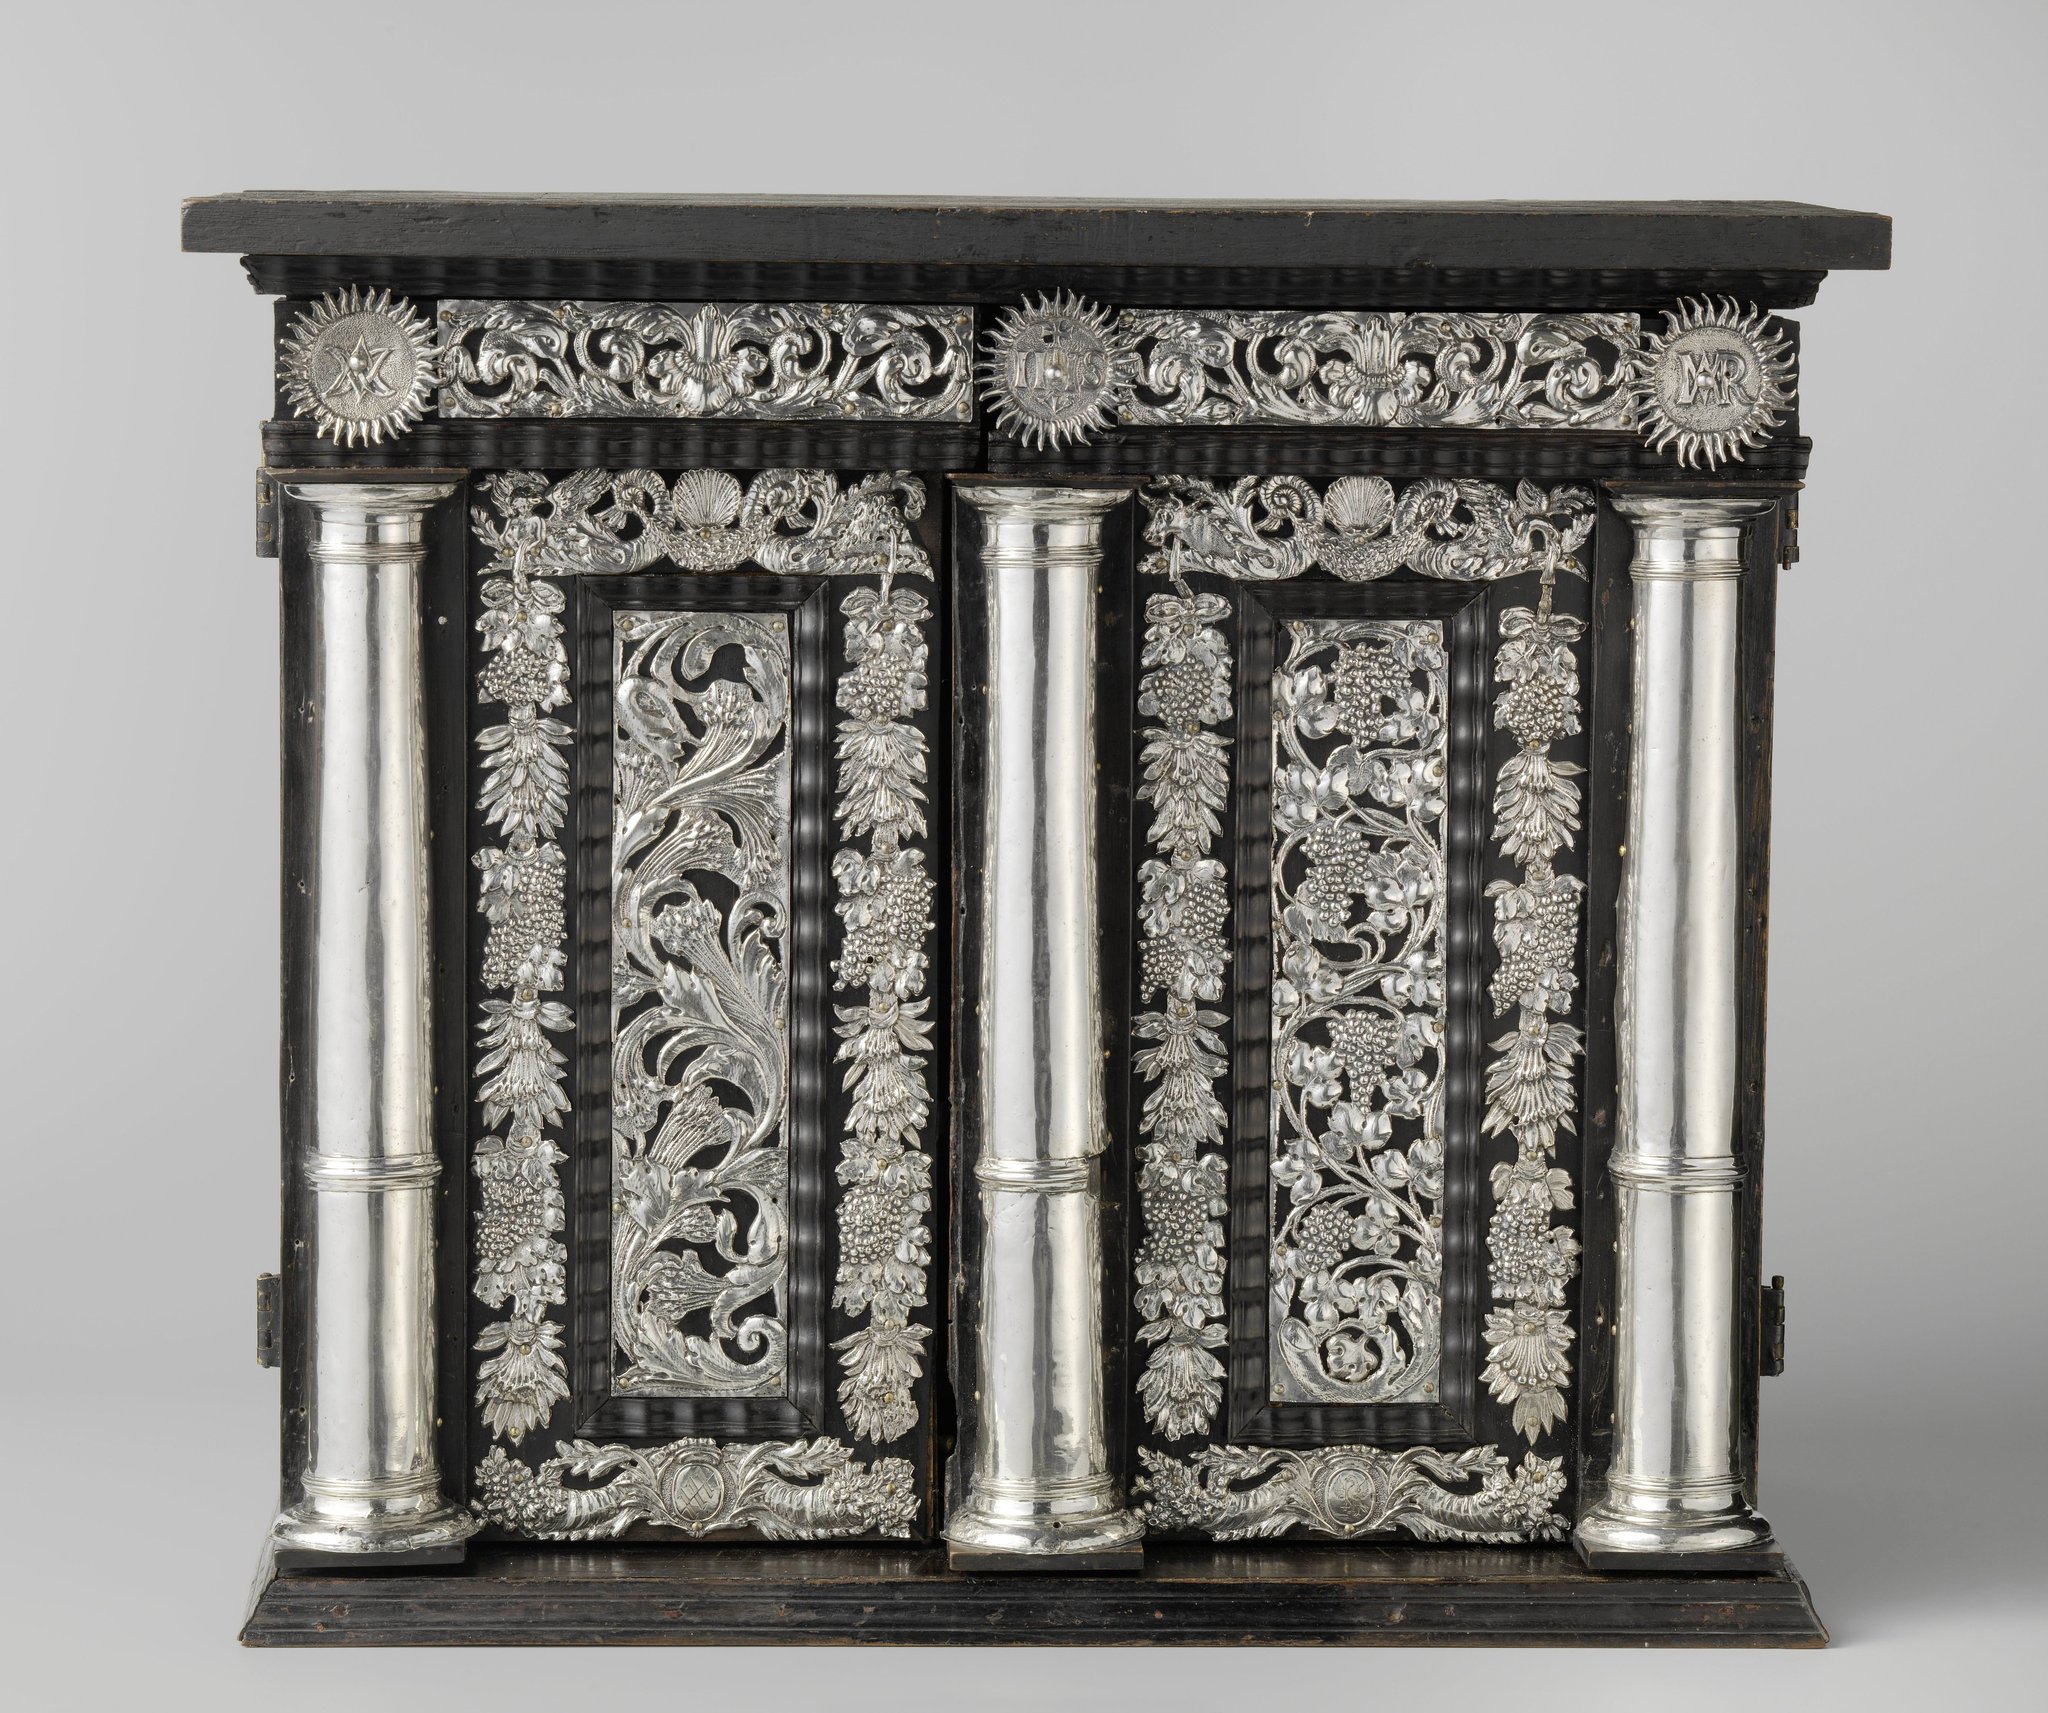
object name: tabernakelkast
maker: Anonymous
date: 1650-1675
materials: brass, wood, silver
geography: friesland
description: Tabernakelkast van ebbenhout met zilverbeslag. De drie uitspringende kolommen zijn omkleed met zilver. Op de deuren en kroonlijsten, opengewerkt, gedreven zilverbeslag.